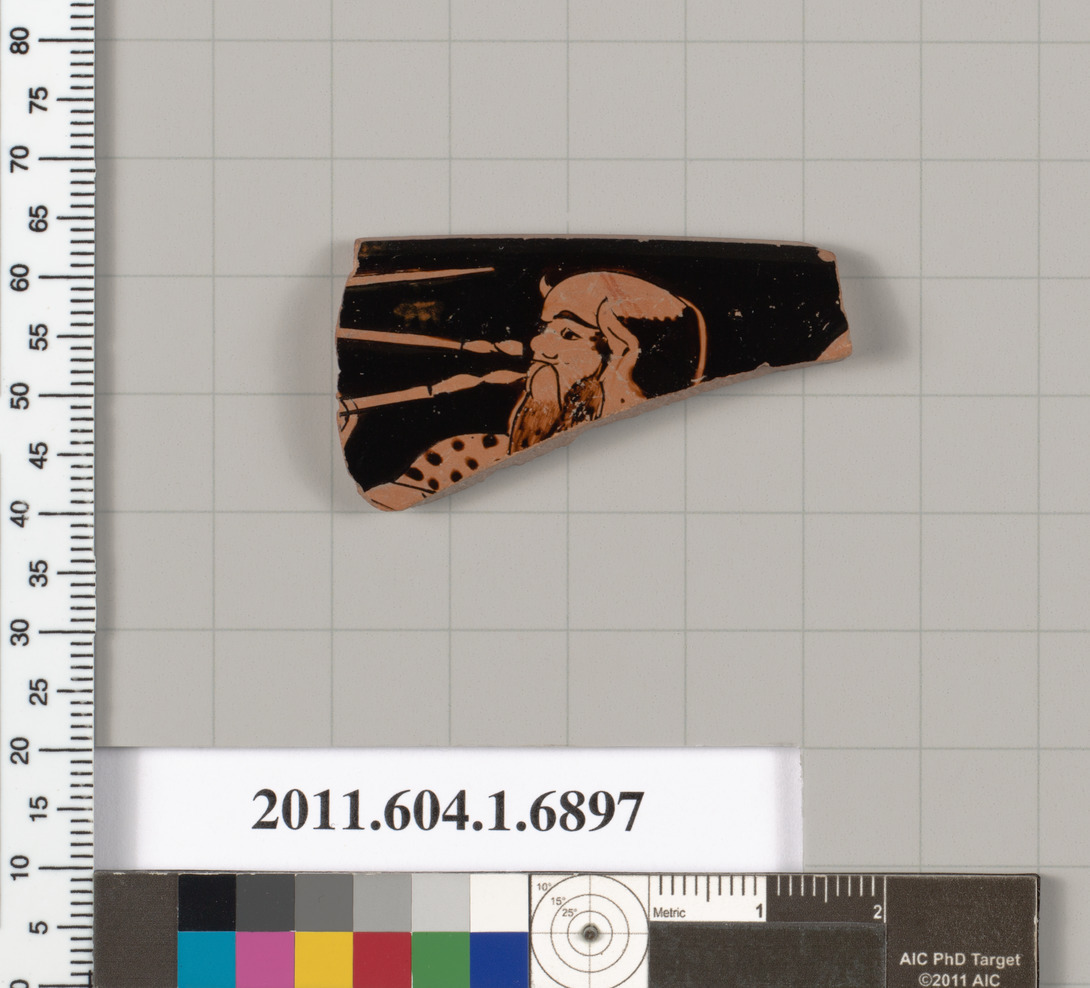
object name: kylix fragment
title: Terracotta rim fragment of a kylix (drinking cup)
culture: greek, attic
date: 490-470 BCE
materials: terracotta